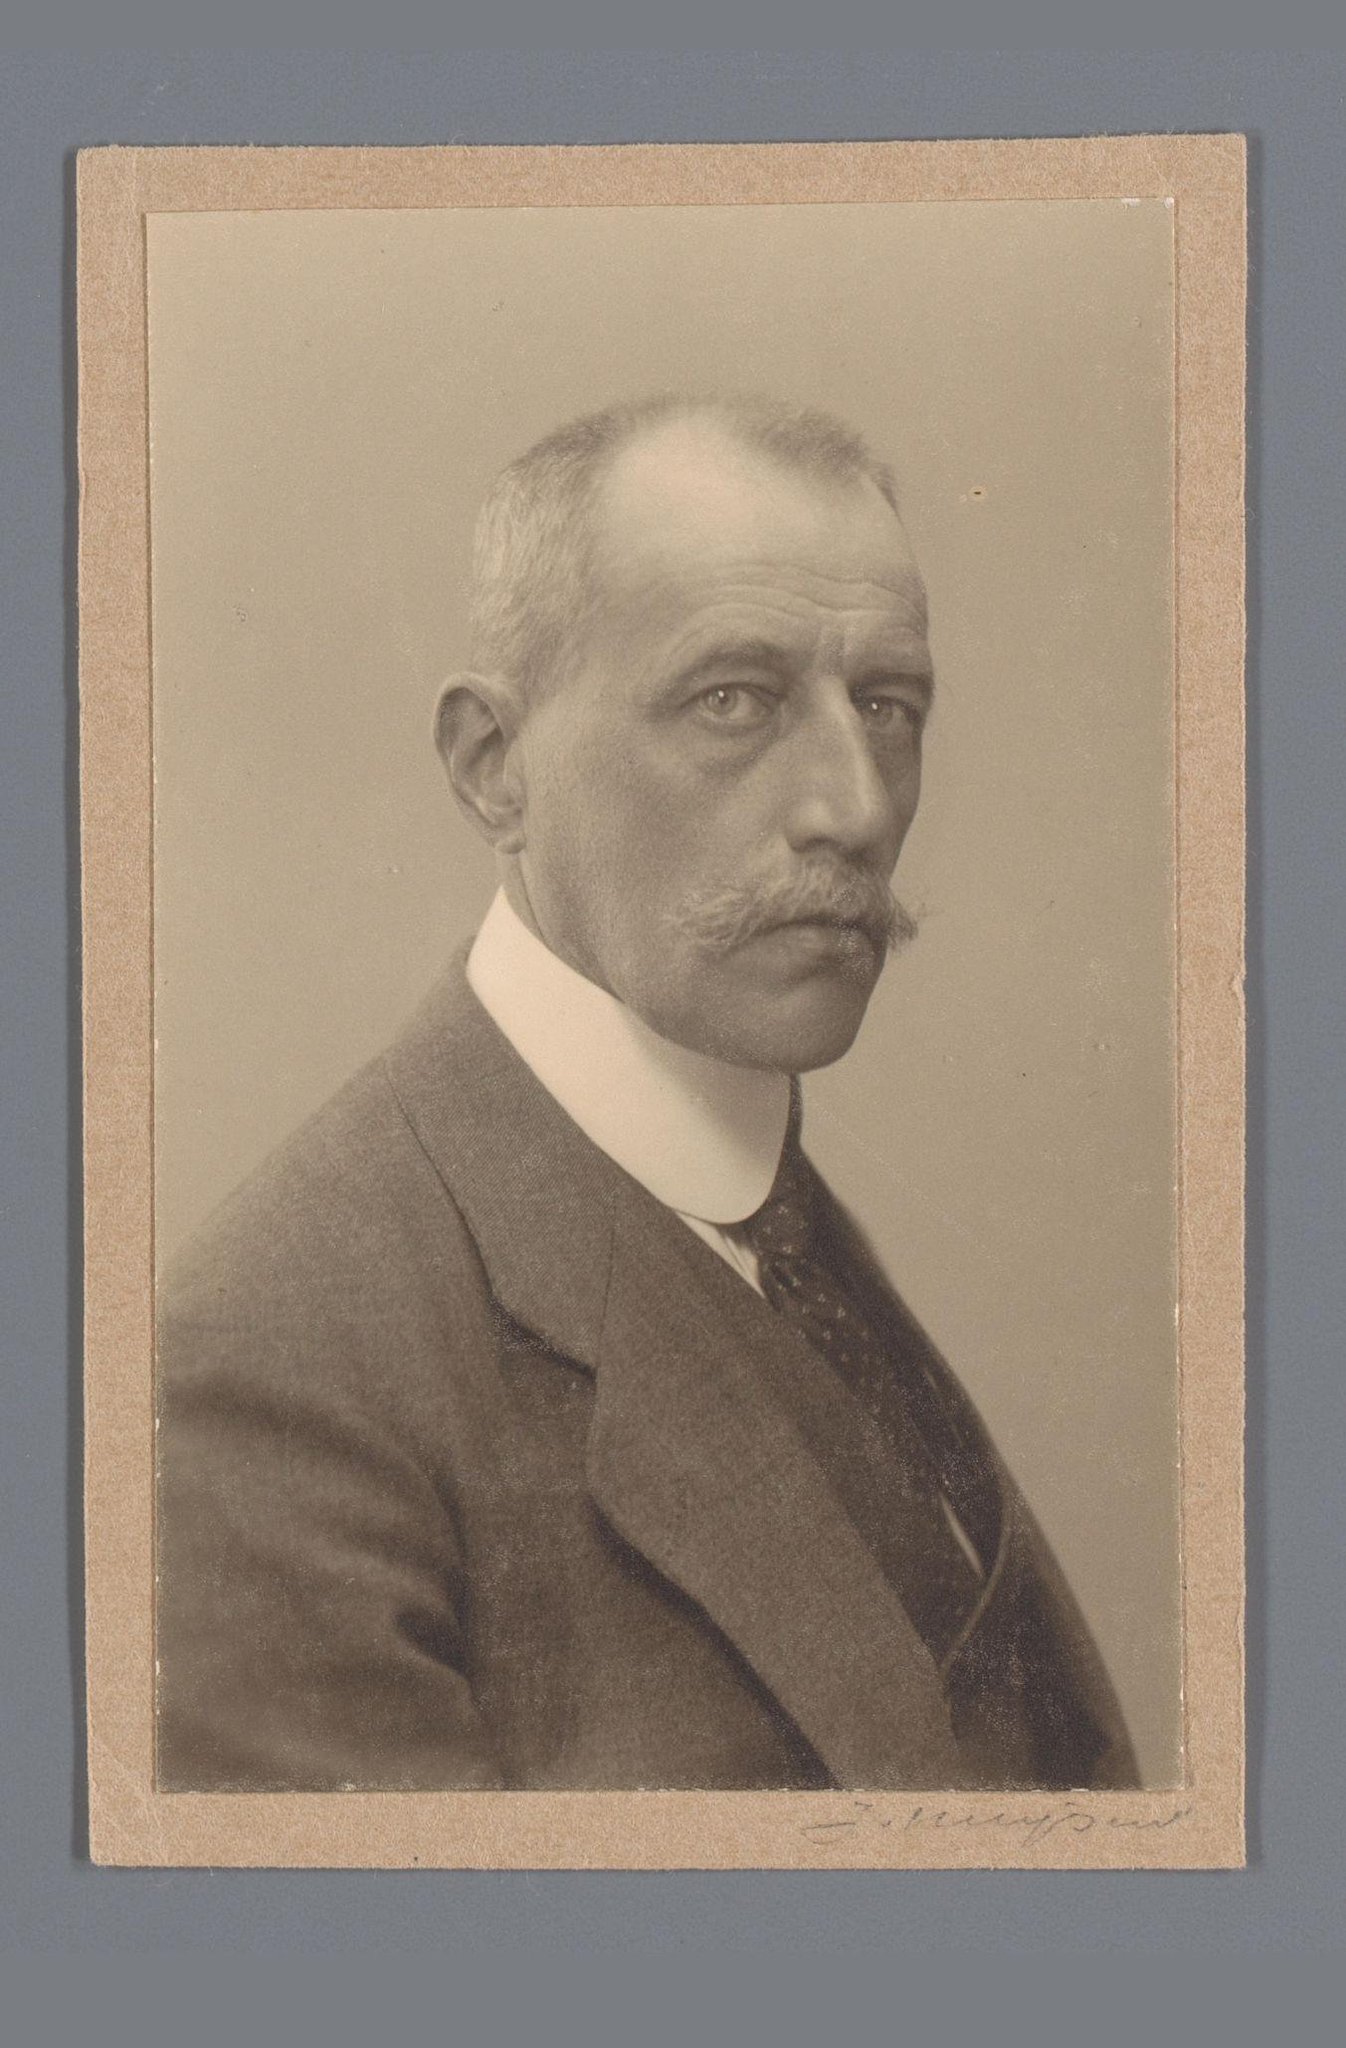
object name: photograph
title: Portret van een onbekende man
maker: Anonymous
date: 1880-1940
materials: cardboard, photographic support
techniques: collodion silver print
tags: historical persons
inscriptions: annotation: ‘J. [...]’, annotation: ‘Jodeboer’